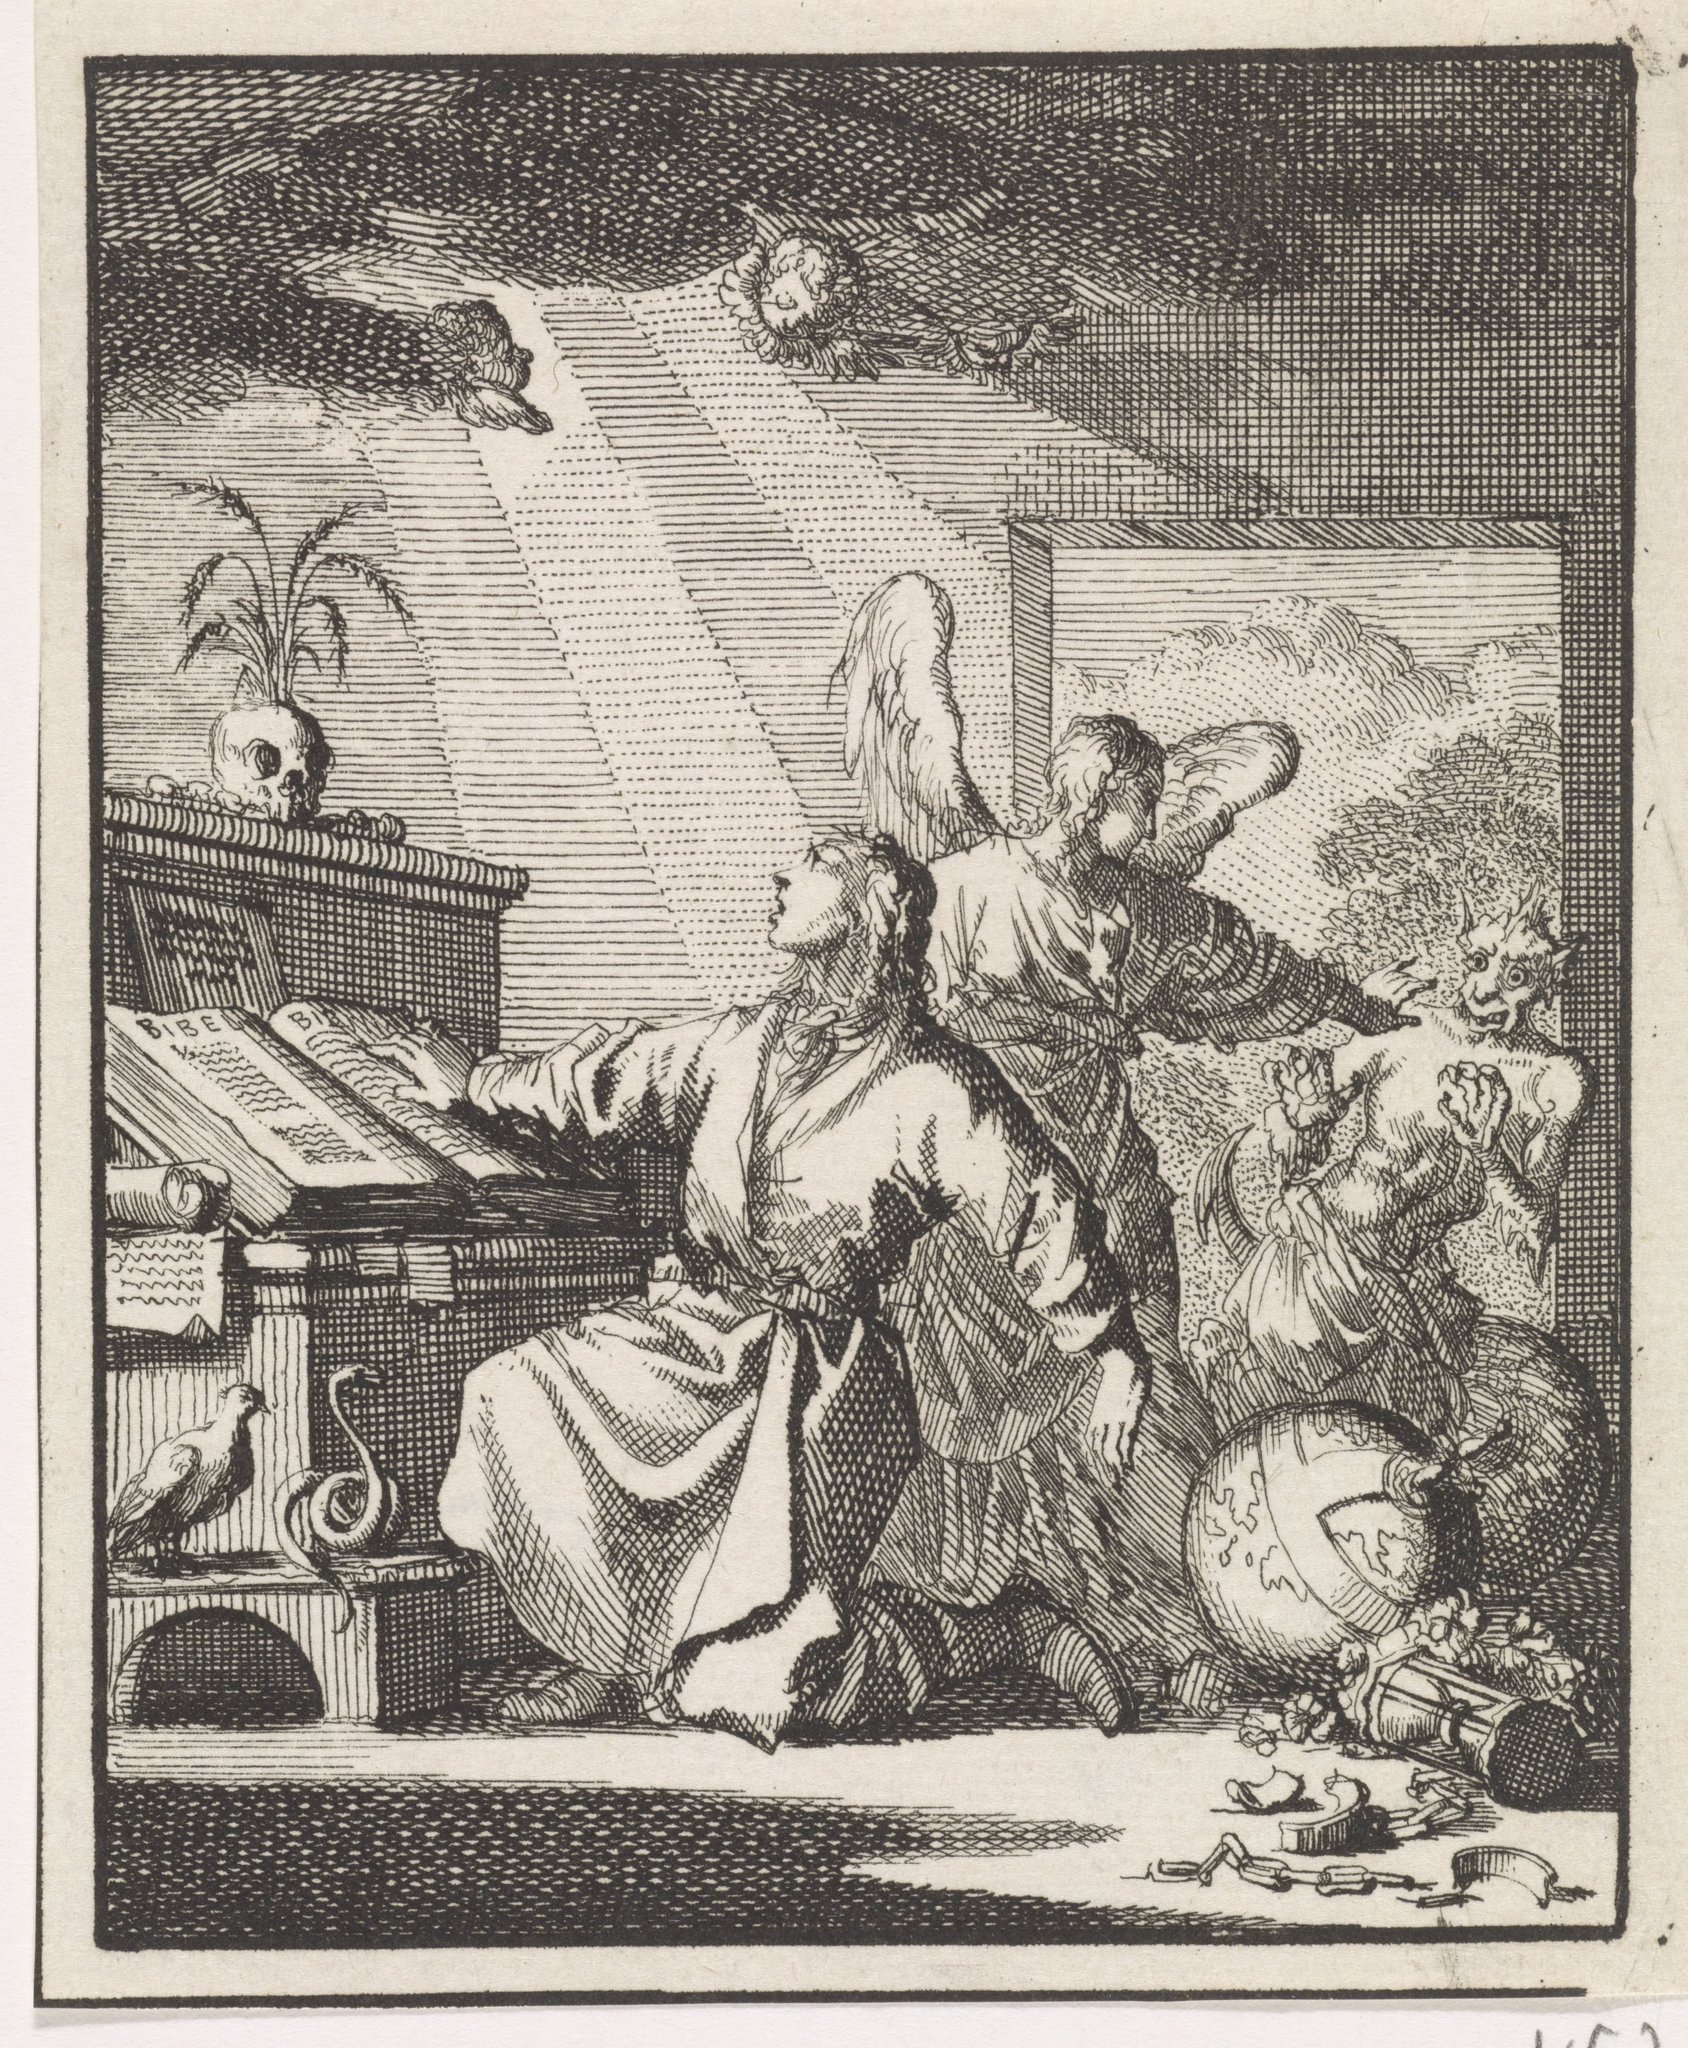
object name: book illustration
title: Man knielt voor een bijbel terwijl een engel de duivel verjaagt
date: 1700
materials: paper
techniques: etching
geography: amsterdam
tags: devil(s) and demons, 'vanitas' symbols, reading the bible or other religious books, light shining out of the heavens, 'mondo', 'machina del mondo' (ripa), angels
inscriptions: collector's mark: Lugt 2228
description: Een man leest knielend een bijbel op een lessenaar. Licht straalt uit de hemel op hem neer. Een engel verjaagt de duivel die het vertrek tracht binnen te komen. Achter de man een wereldbol, een zandloper en gebroken ketenen.